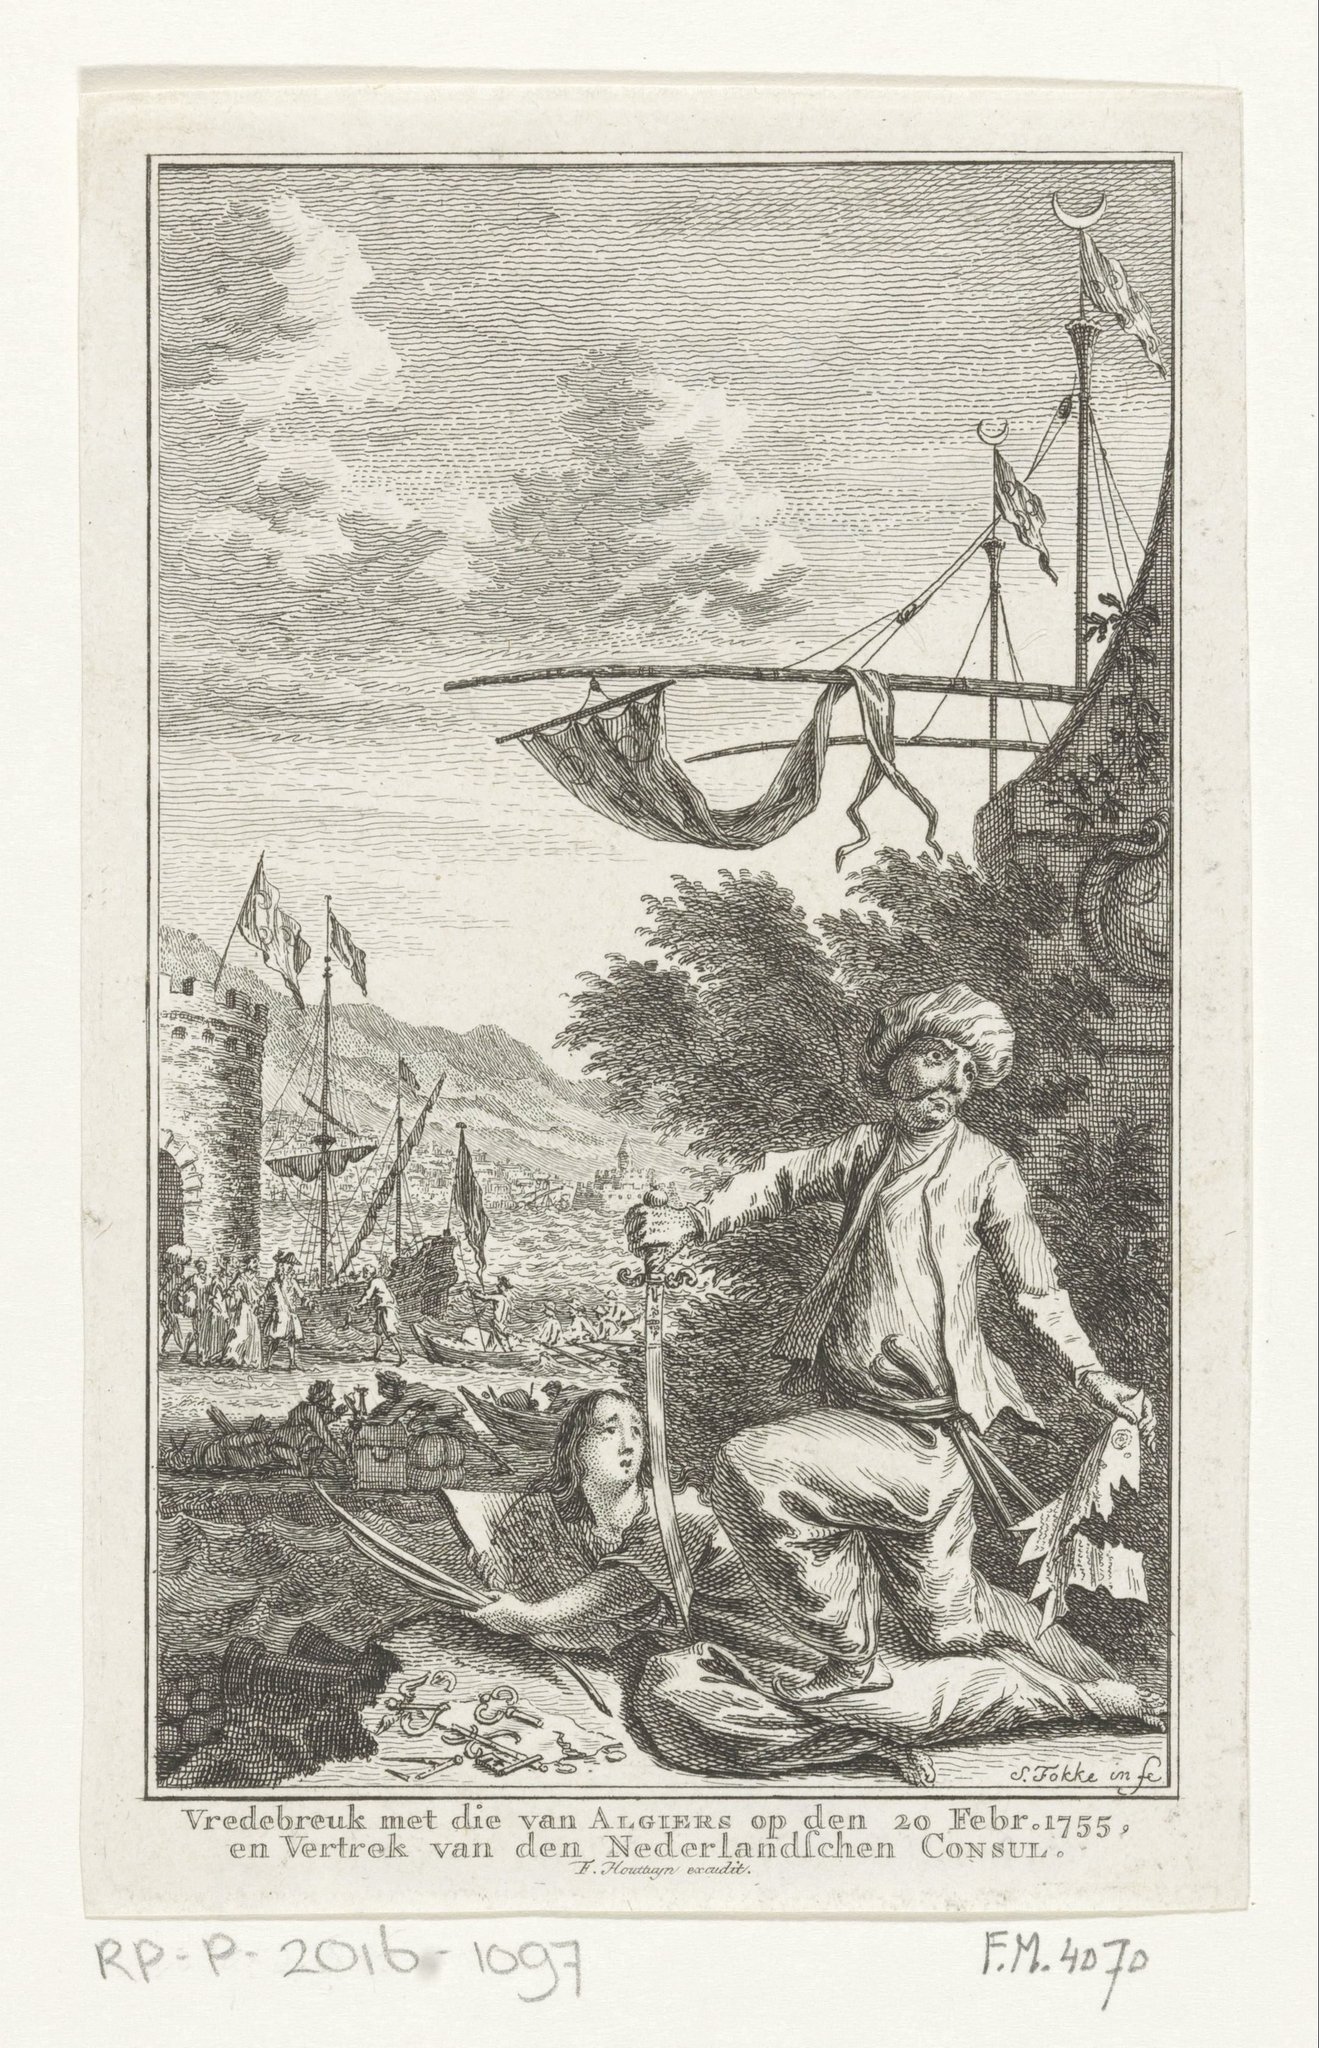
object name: book illustration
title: Allegorie op de vredebreuk met Algiers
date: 1755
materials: paper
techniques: engraving, etching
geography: amsterdam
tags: pirate, corsair, buccaneer, trampling, treading, stamping on someone or something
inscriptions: collector's mark: Lugt 2228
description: Prent uit: S.n. Nederlandsche jaerboeken, inhoudende een Verhael van de merkwaerdigste geschiedenissen, die voorgevallen zyn binnen den omtrek der Vereenigde Provintien, sederd het begin des jaers MDCCXLVII, negende deel. Amsterdam: Houttuyn, Frans, 1755. Prent afkomstig uit een plakalbum met titelprenten, ornamenten etc. op blauw papier in 1983 uit elkaar gehaald.